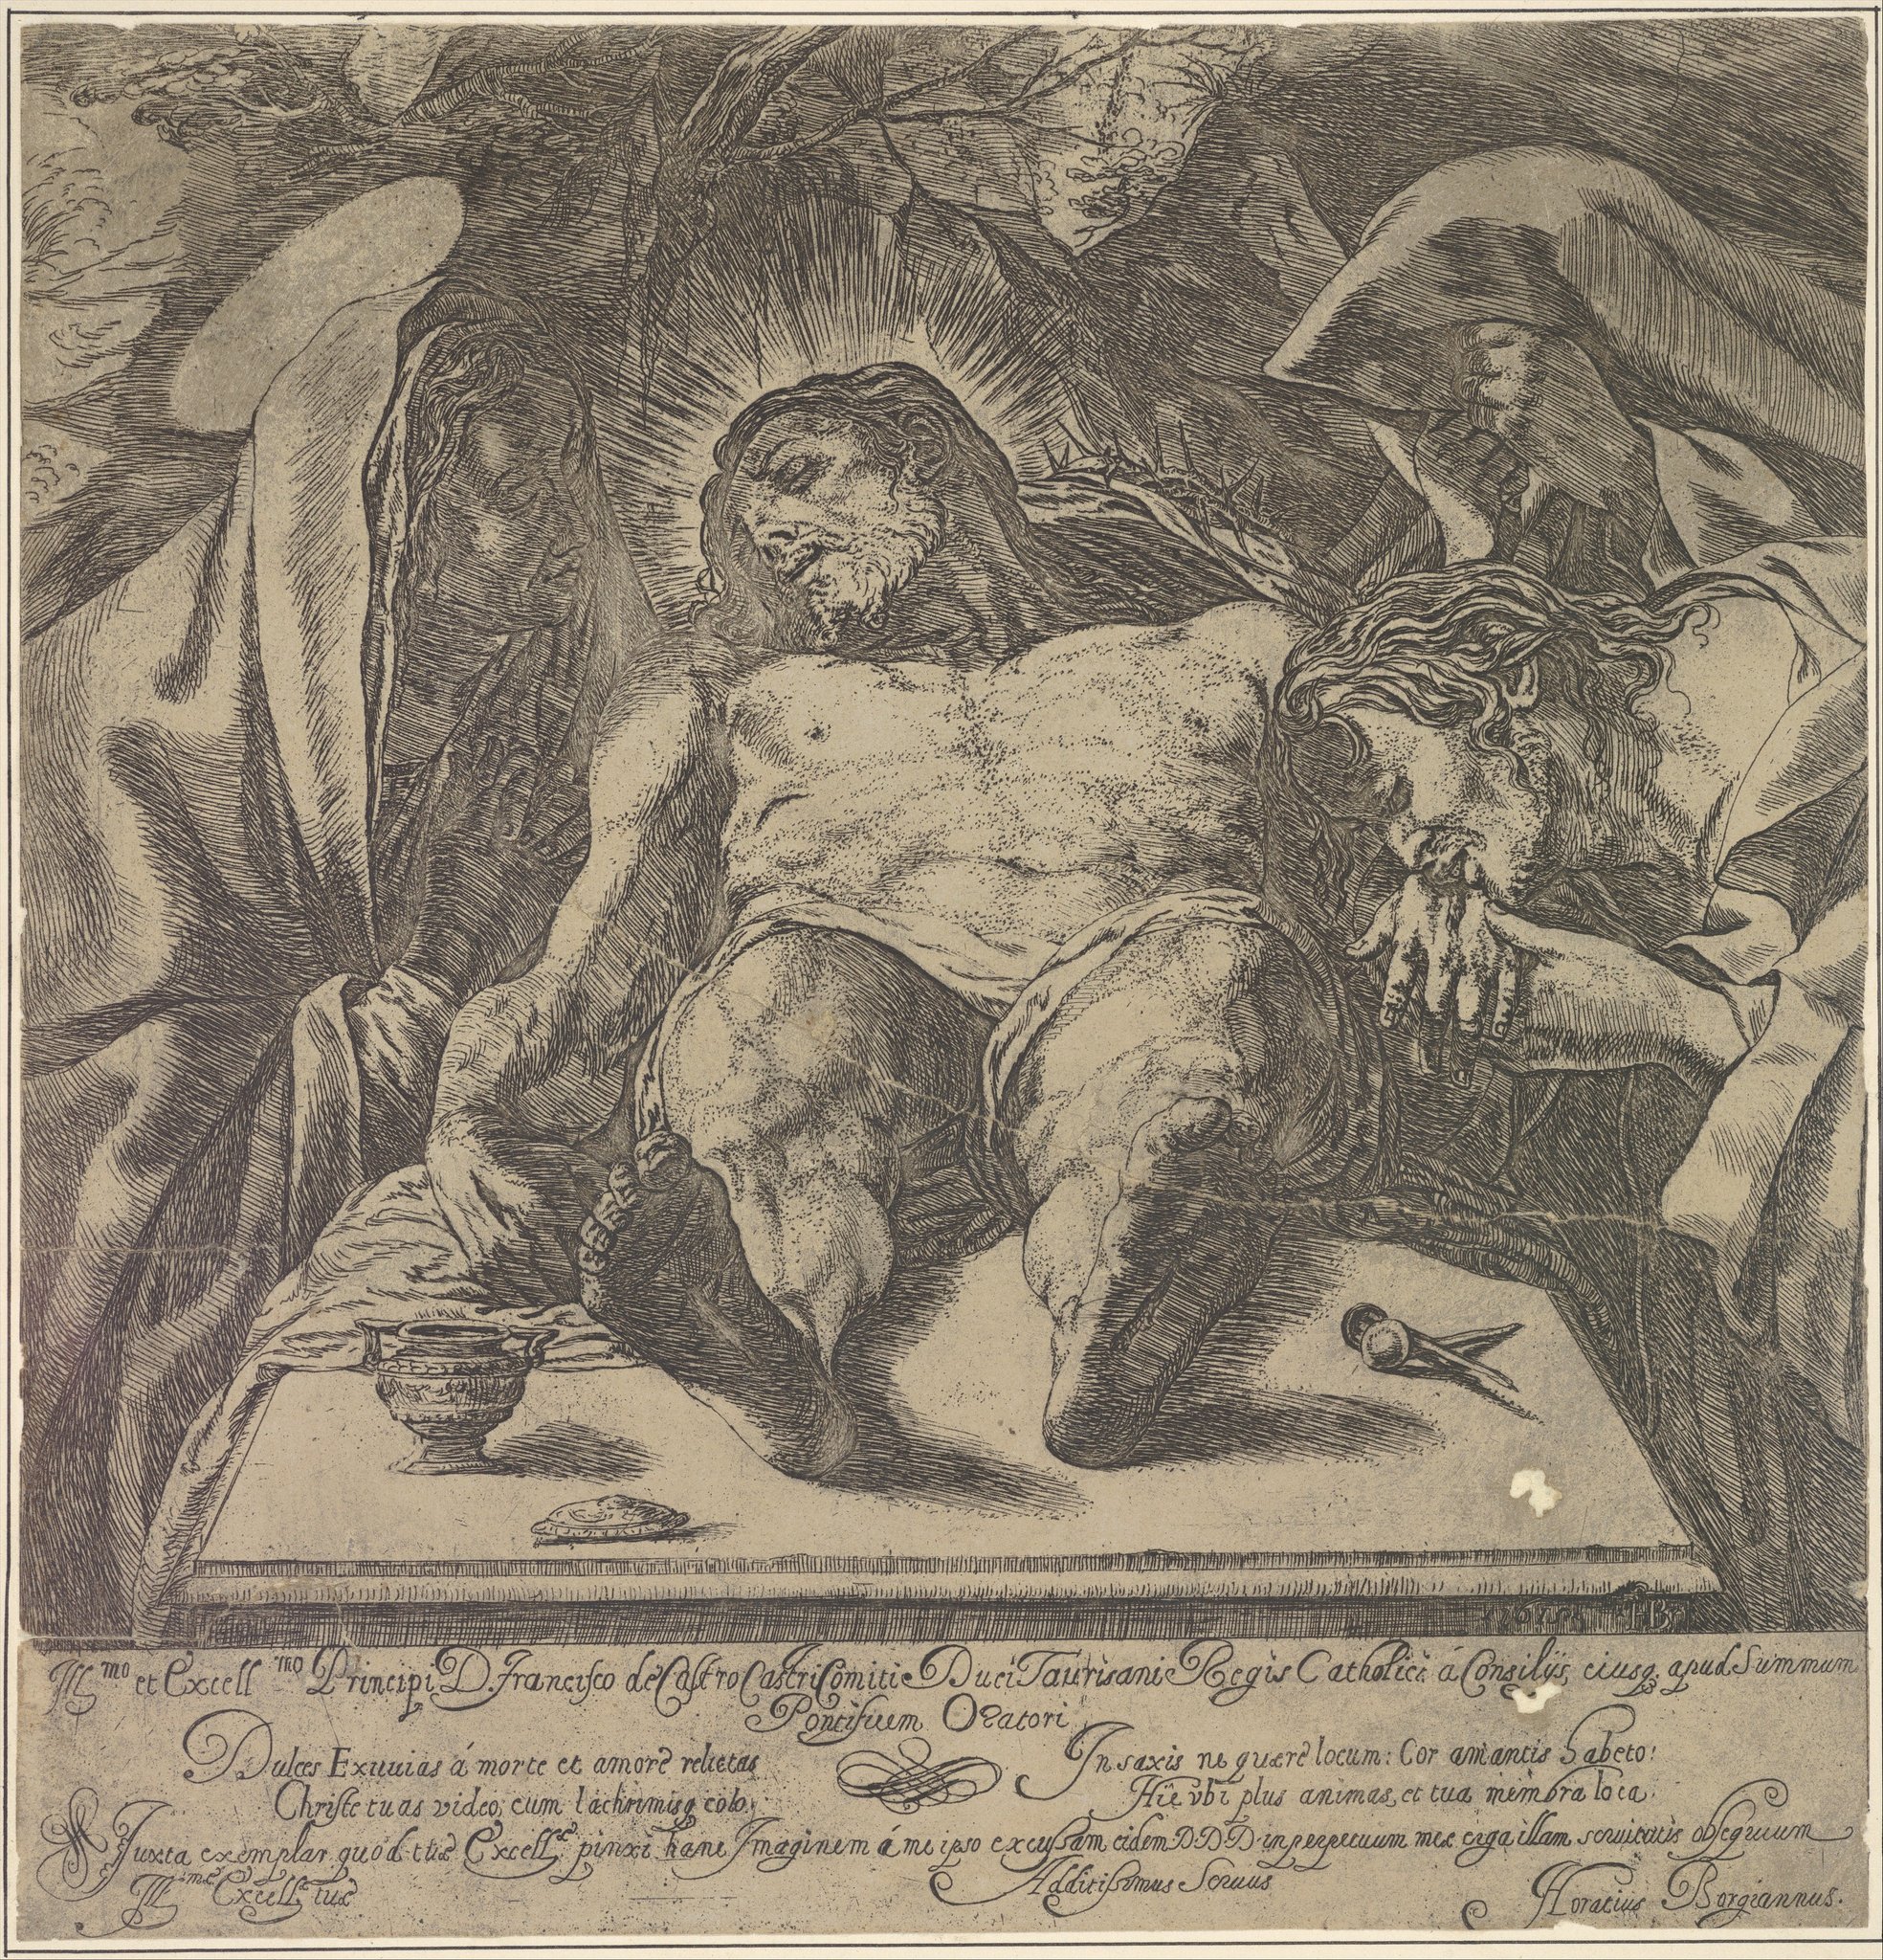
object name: print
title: Lamentation over the body of Christ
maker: orazio borgianni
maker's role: artist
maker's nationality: italian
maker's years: 1578-1616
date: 1615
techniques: etching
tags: christ,lamentation